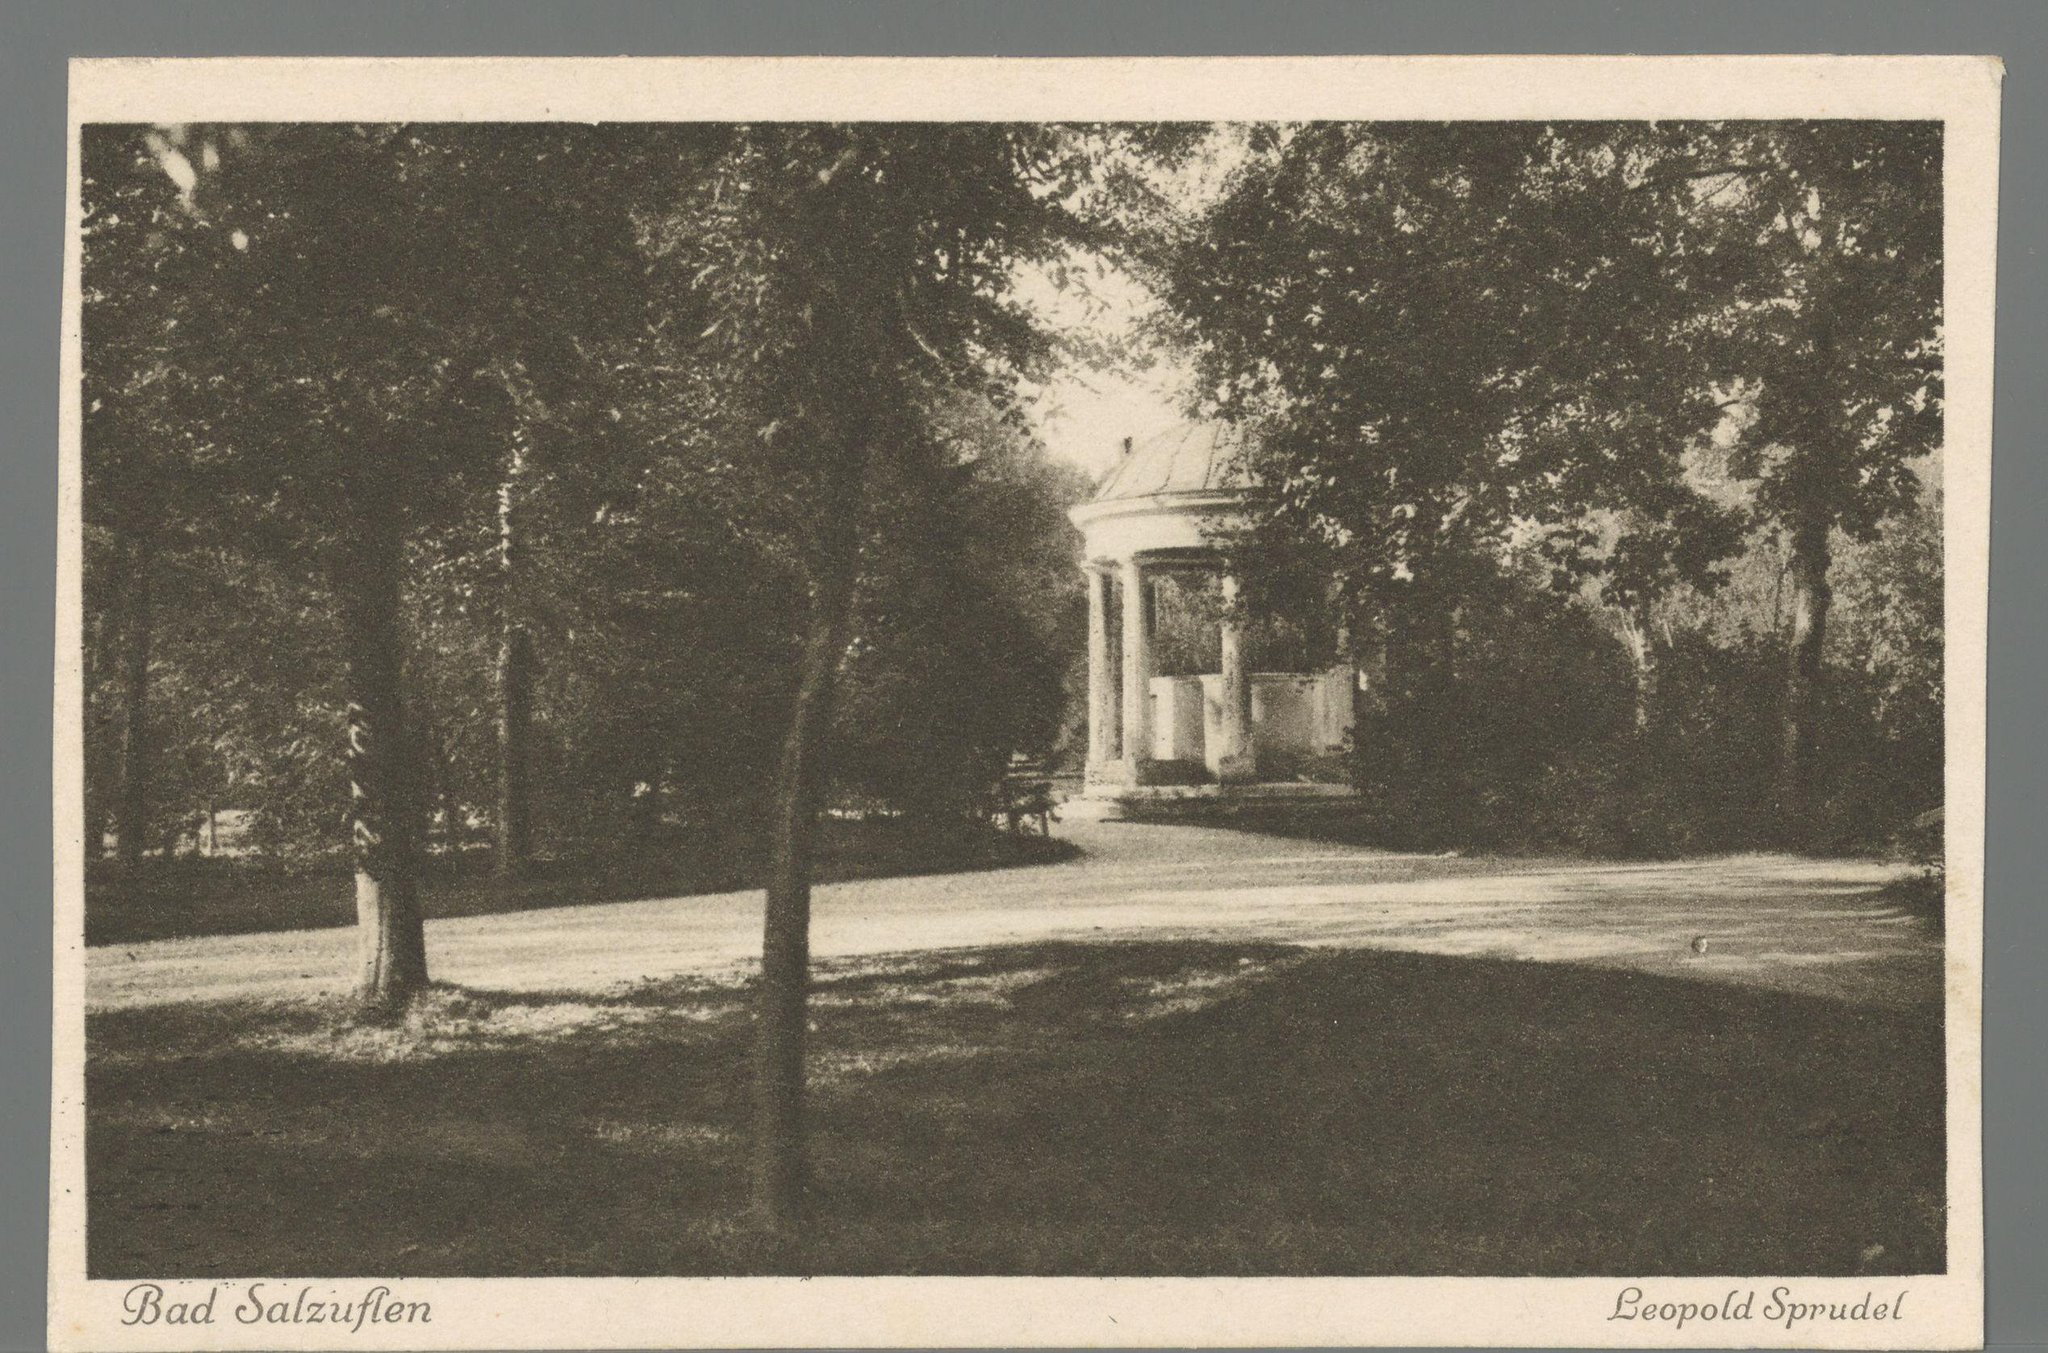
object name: ansichtkaart, prentbriefkaart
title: Bad Salzuflen. Leopold Sprudel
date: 1905-1930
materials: cardboard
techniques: rotogravure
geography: bad salzuflen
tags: well, watering-place, spa